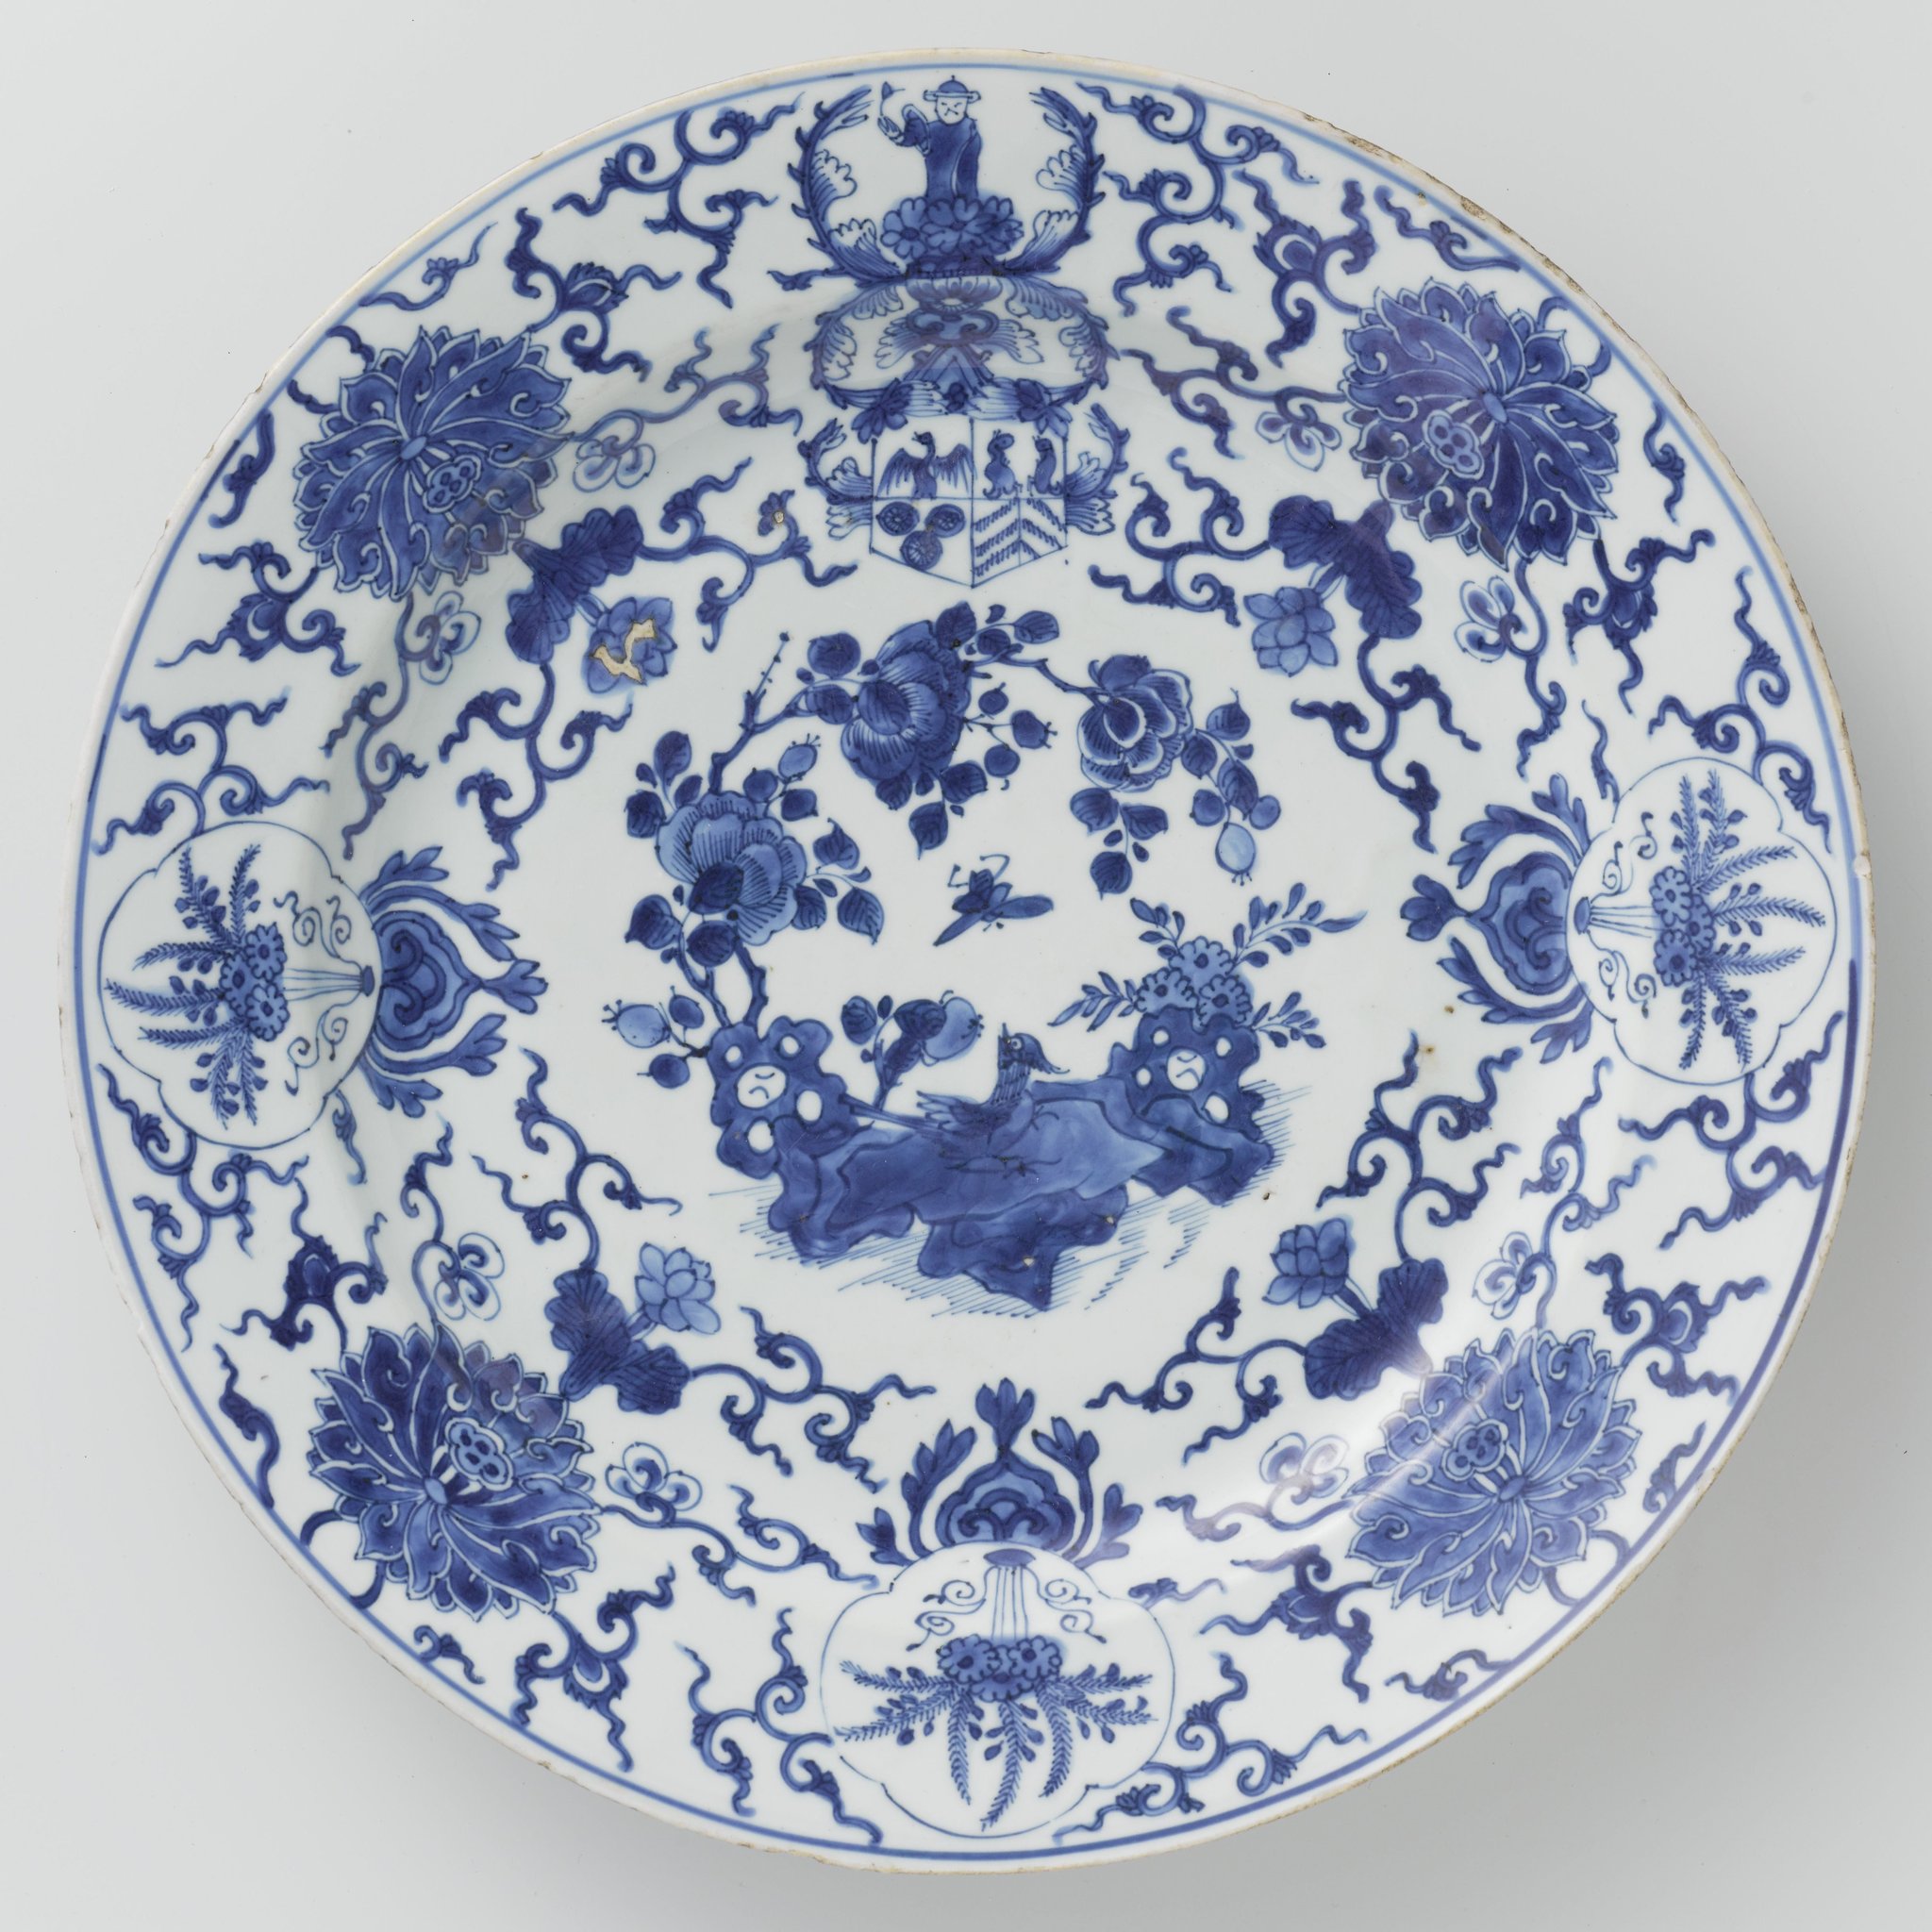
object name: platter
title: Dish with the arms of the Pelgrom family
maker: Anonymous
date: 1680-1699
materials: cobalt, glaze, paint, porcelain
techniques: firing, turning, vitrification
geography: china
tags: batavia, flowers ~ ornament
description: The Pelgrom family coat of arms is painted on the upper centre rim of the dish. It was part of a dinner service made for Jacob Pelgrom, a merchant who rose to become Director-General of Bengal (India).